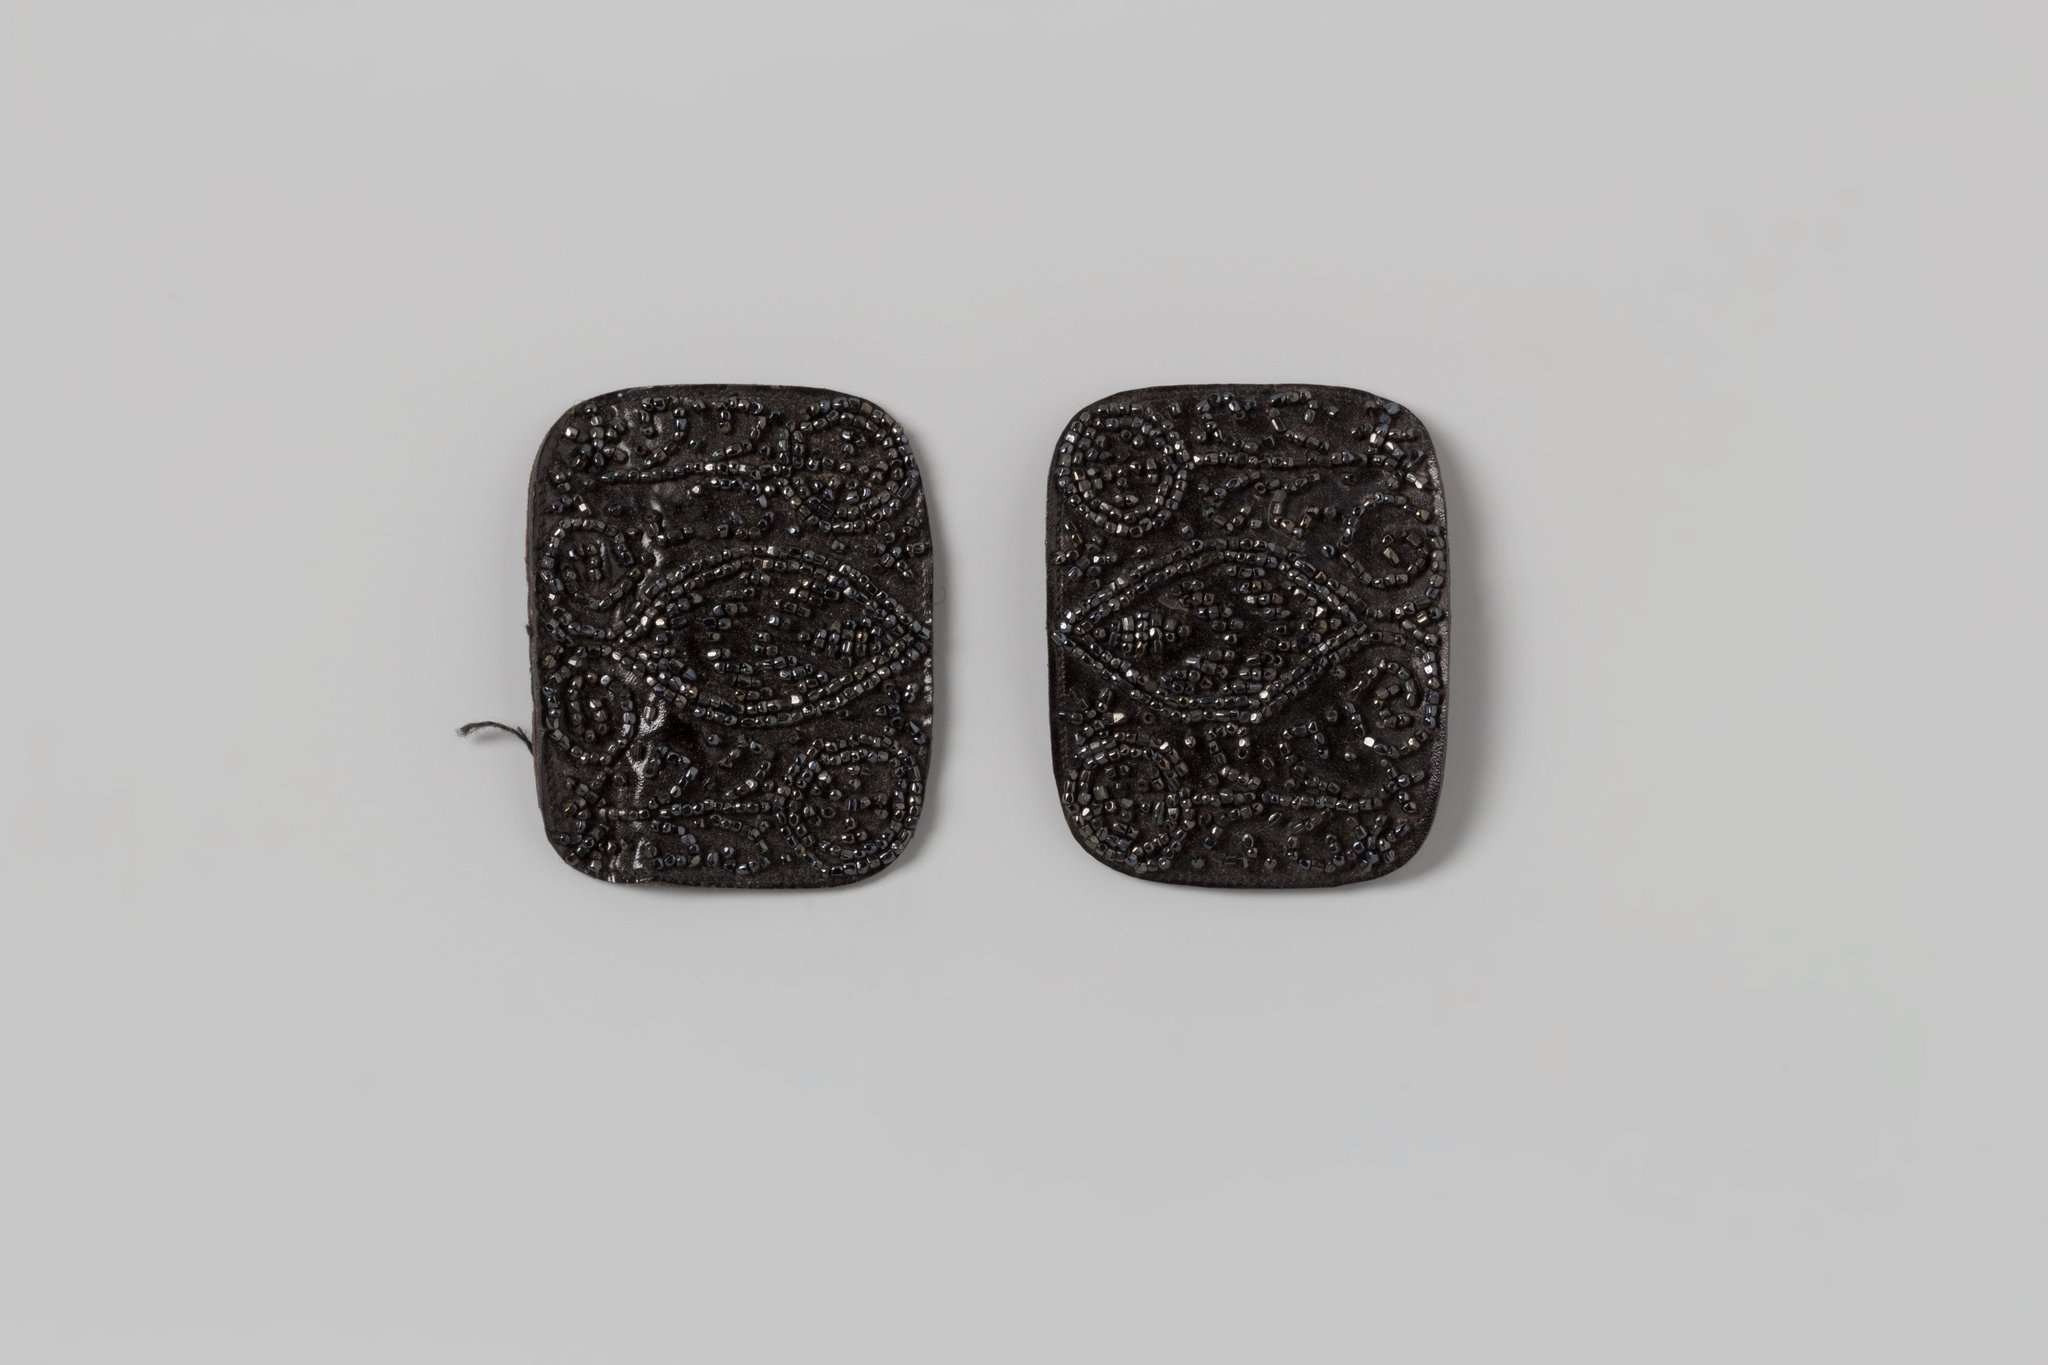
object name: shoe buckle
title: Schoengesp van zwart leer geborduurd met gitten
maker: Anonymous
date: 1915-1920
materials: jet, leather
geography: france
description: Schoengesp van zwart leer geborduurd met gitten. Rechthoekig gesloten model van zwart leer op een verstevigde ondergrond. Het borduursel bestaat uit een ovaal blad, geflankeerd door twee ronde bloemen op een stengel.